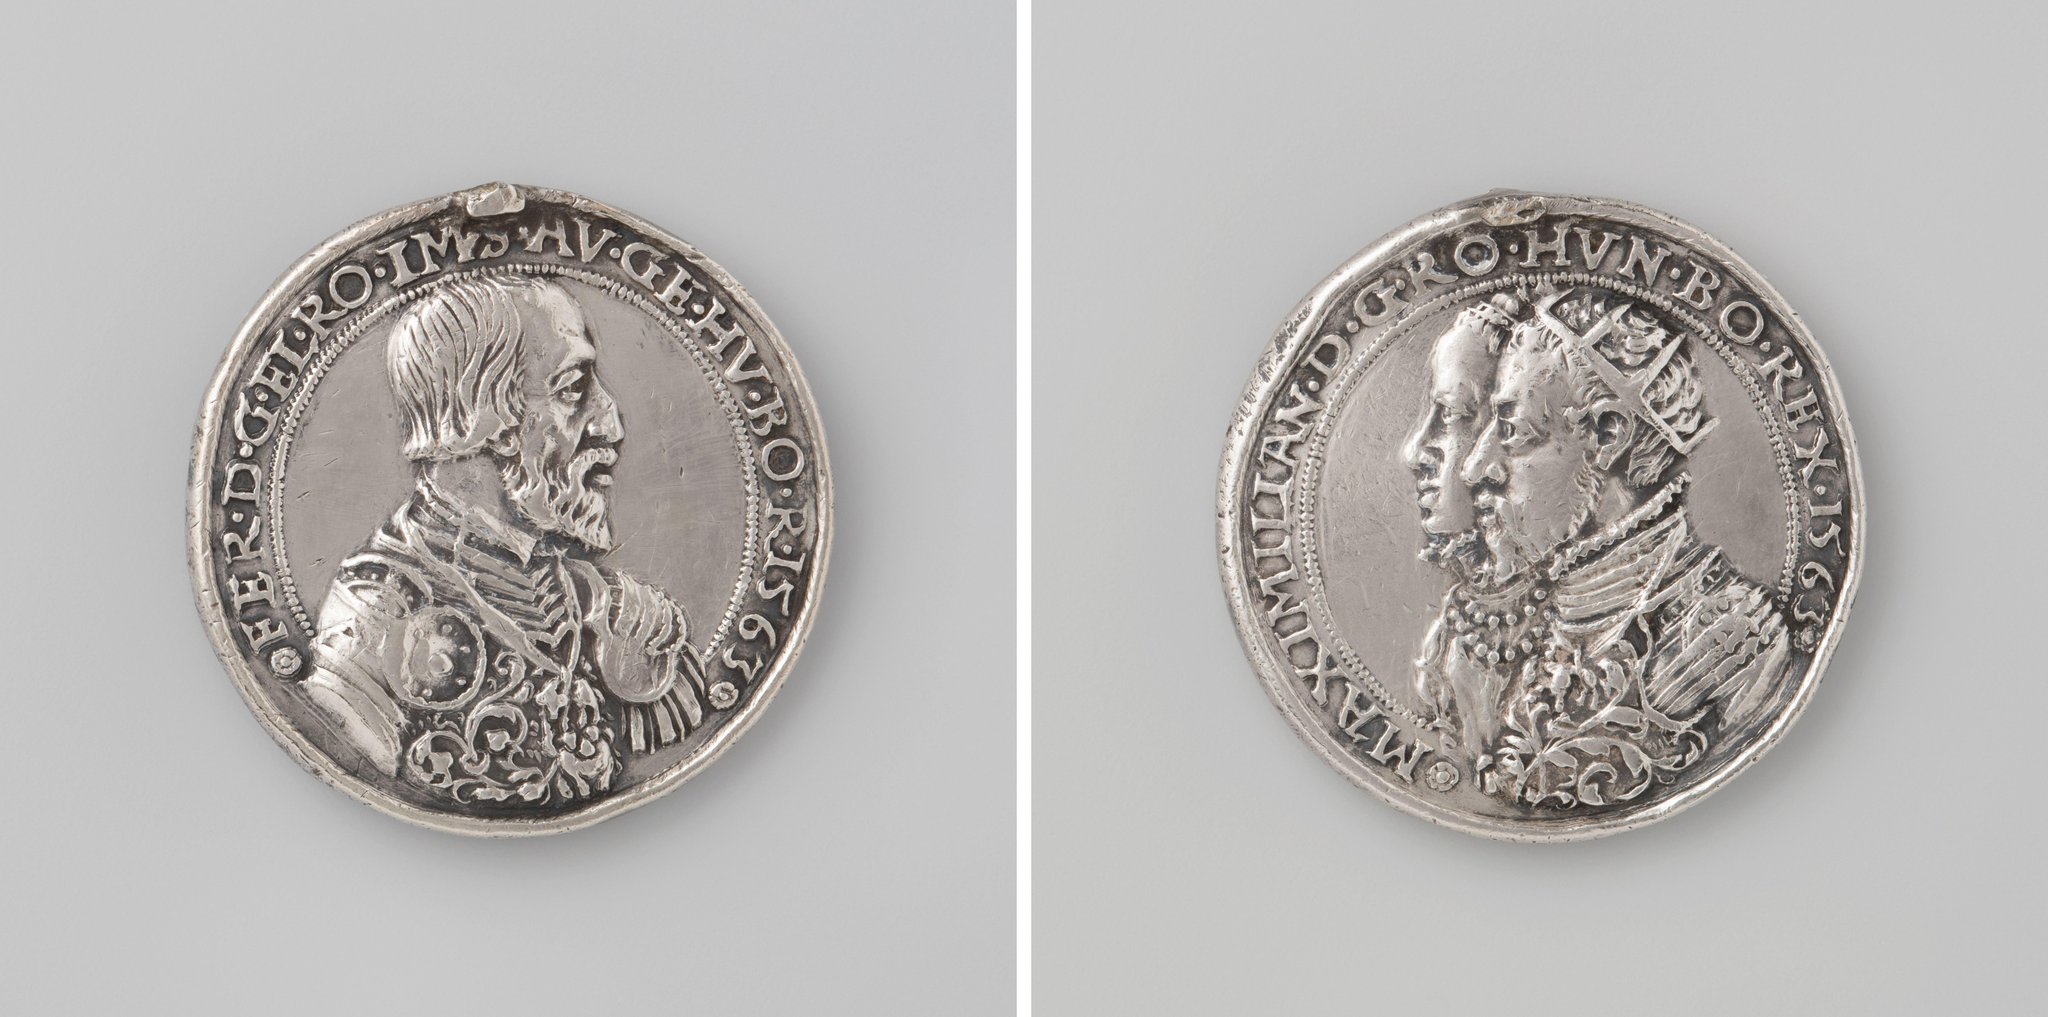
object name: history medal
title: Ter ere van Ferdinand I, Duits keizer, zijn zoon Maximiliaan II en diens vrouw Maria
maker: Anonymous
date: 1563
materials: silver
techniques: striking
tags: vienna, ferdinand i van habsburg (duits keizer), maria (koningin van bohemen), maximiliaan ii (keizer van heilige roomse rijk)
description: Zilveren penning met afgebroken draagoog. Voorzijde: borststuk man binnen omschrift. Keerzijde: borststuk man met sterrenkroon en vrouw binnen omschrift